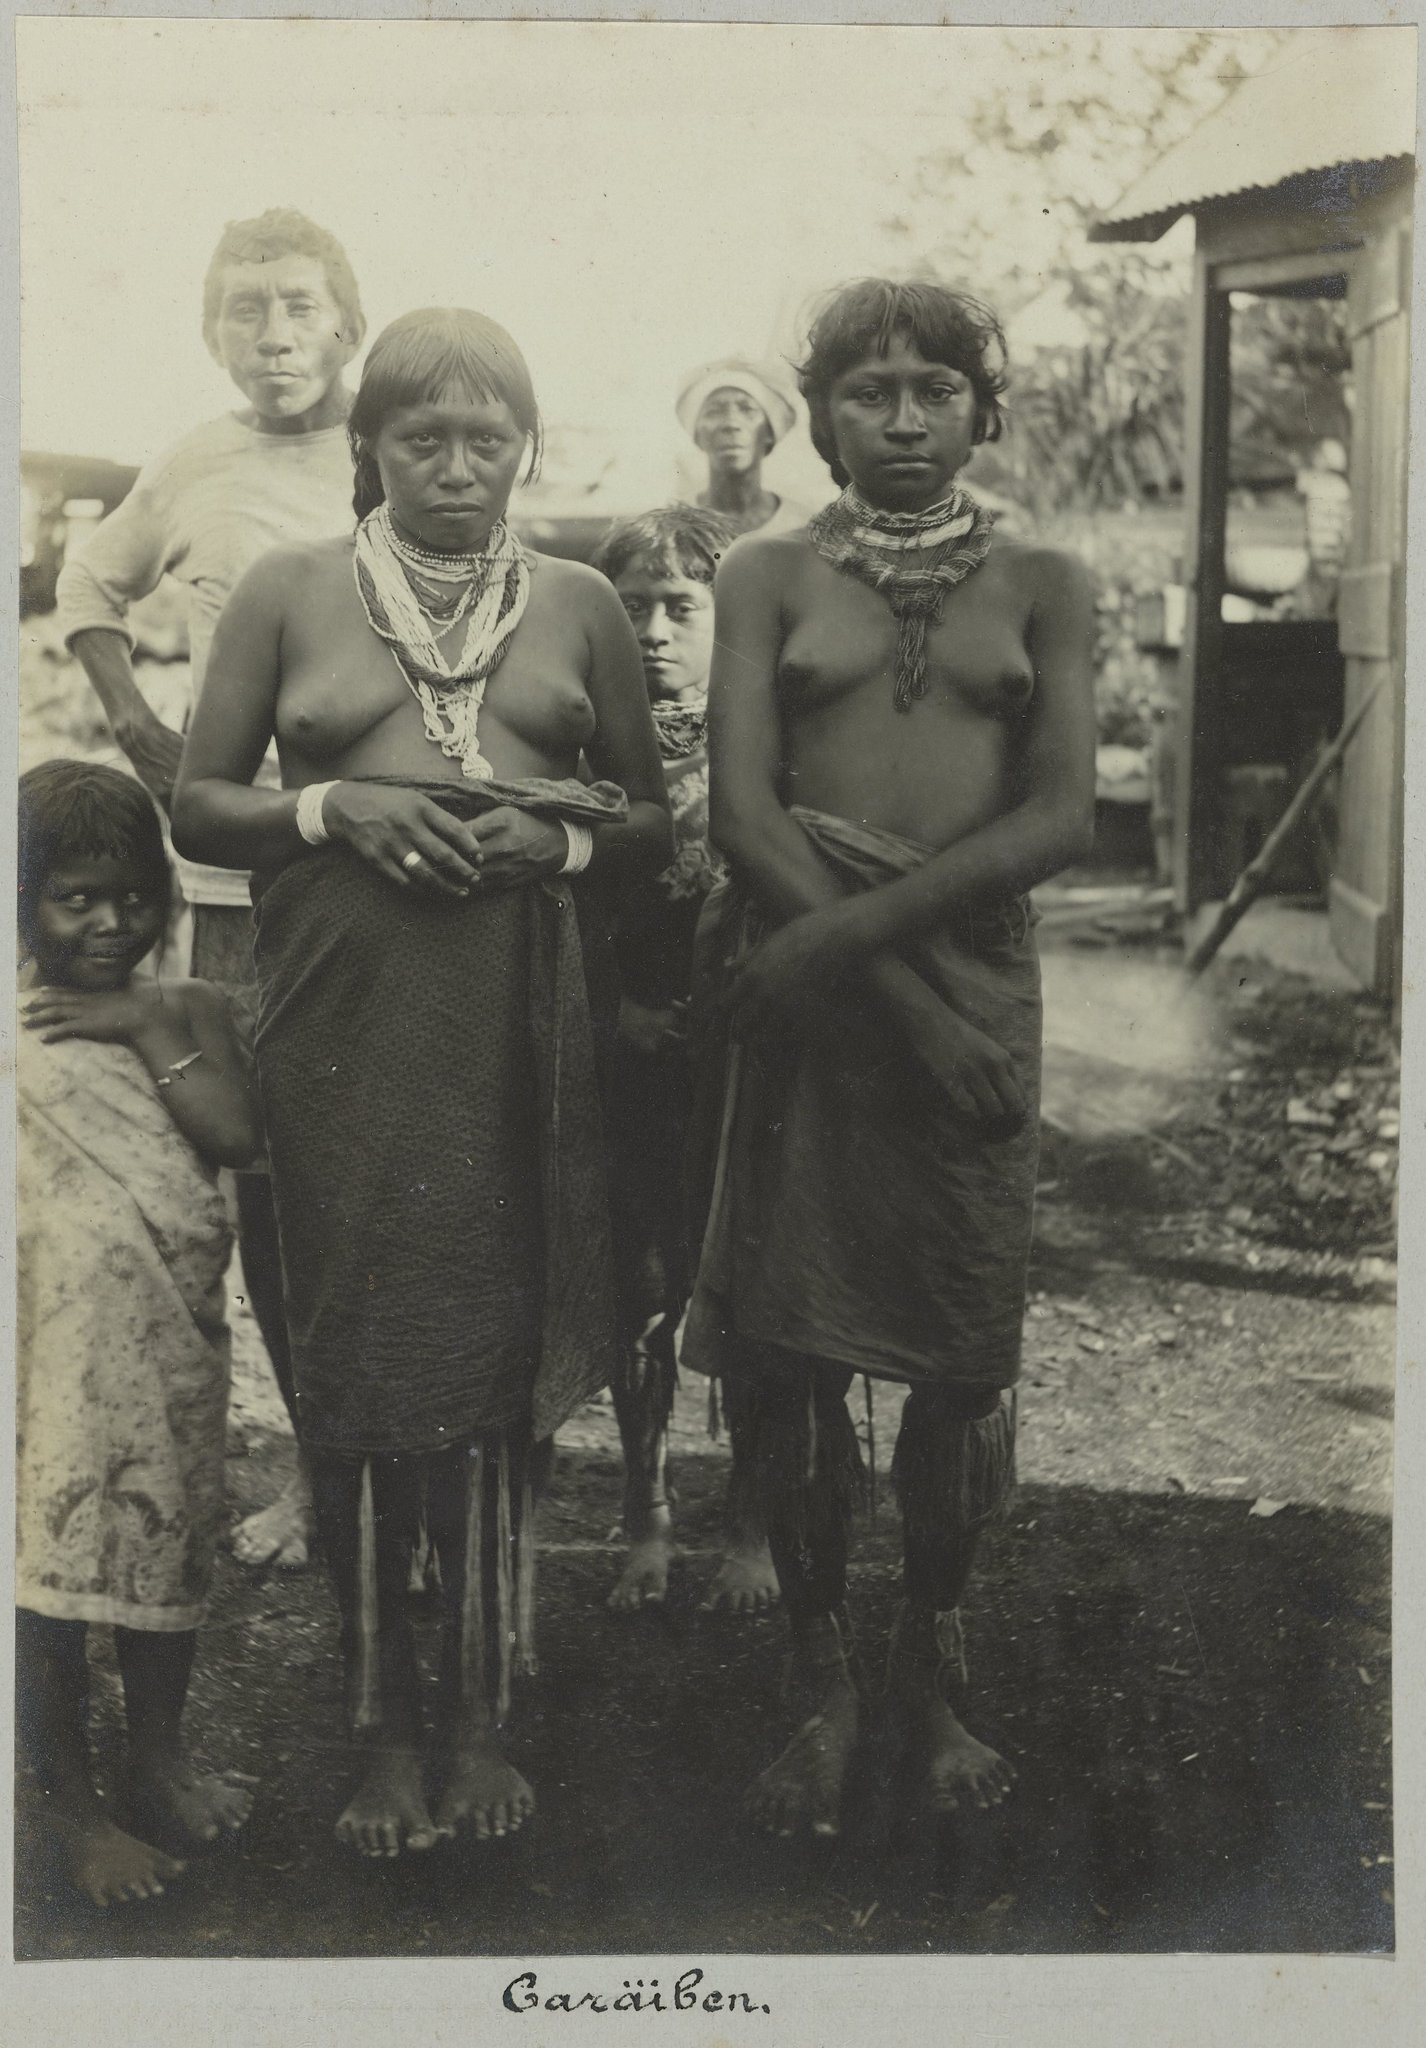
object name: photograph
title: Surinaamse Caraïben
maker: hendrik doijer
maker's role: engineer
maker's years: 1863-1925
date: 1903-1910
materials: photographic support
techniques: gelatin silver print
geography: suriname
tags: indigenous peoples of south america, suriname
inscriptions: inscription: ‘A18 / Caräiben.’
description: Twee staand poserende jonge vrouwen van de Surinaamse Indiaanse Karaïben. Onderdeel van het fotoalbum Souvenir de Voyage (deel 1), over het leven van de familie Doijer in en rond de plantage Ma Retraite in Suriname in de jaren 1903-1910.